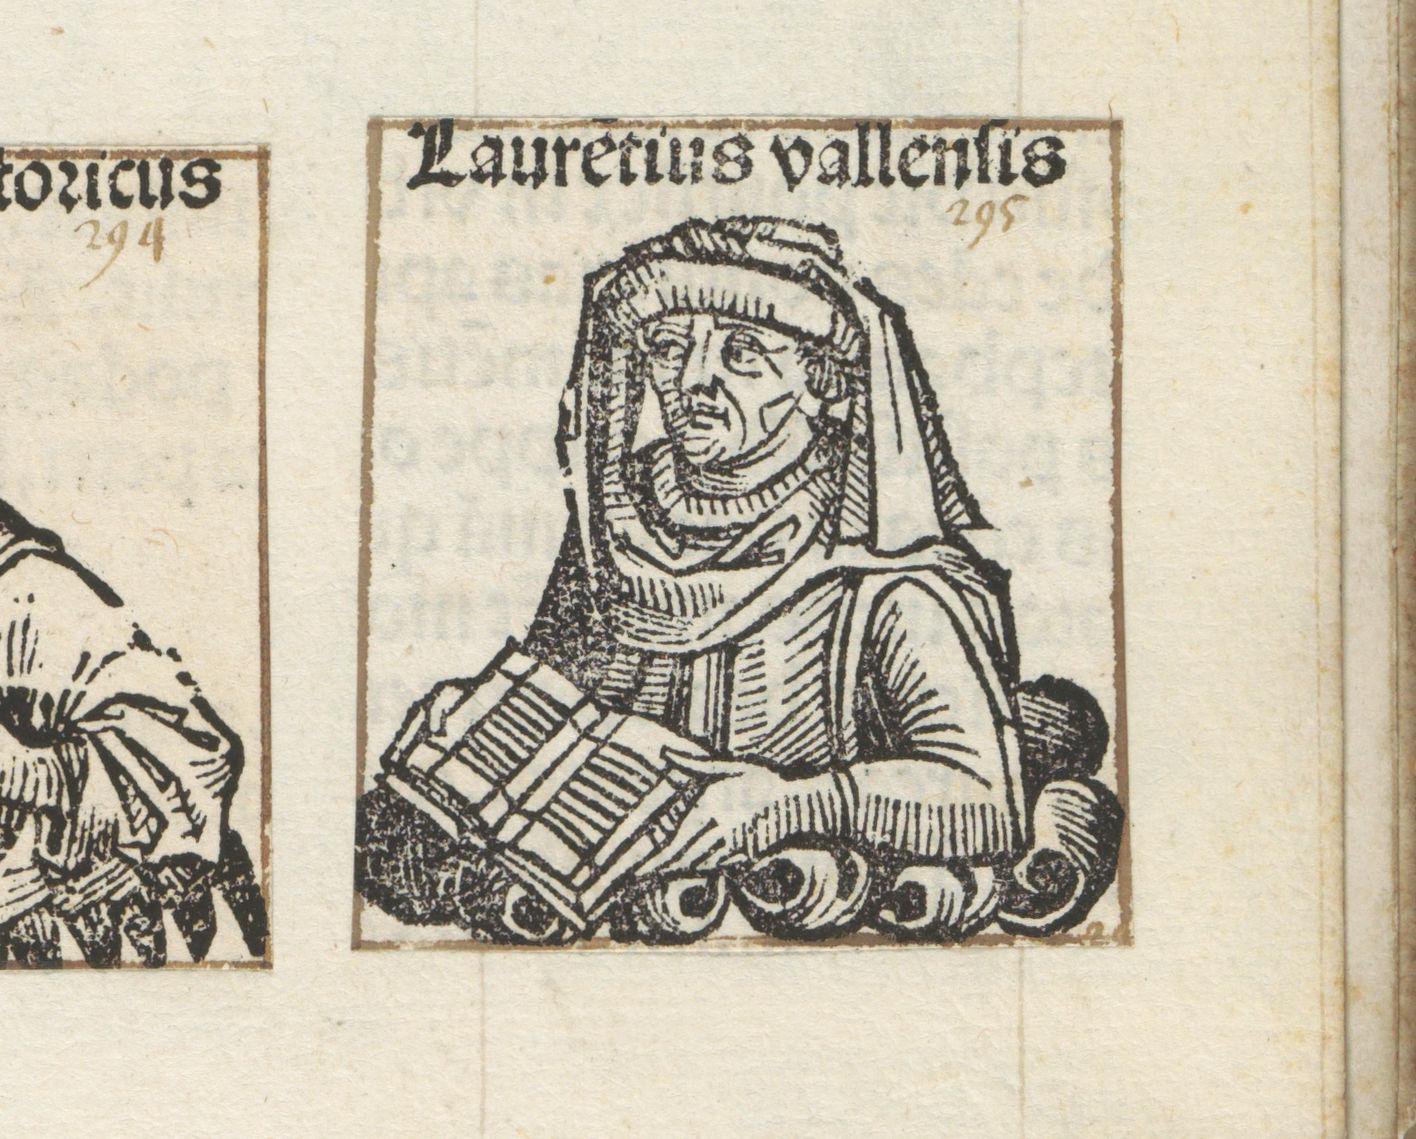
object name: album leaf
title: Laurentius vallensis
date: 1493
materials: paper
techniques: letterpress printing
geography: nuremberg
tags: reading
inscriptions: inscription: ‘294’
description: De houtsnede wordt herhaaldelijk gebruikt als boekillustratie in de Liber Chronicarum (of Neurenbergkroniek) van Hartmann Schedel, verschenen in het Latijn en Duits in 1493. Zie de Latijnse uitgave, folio 246r.